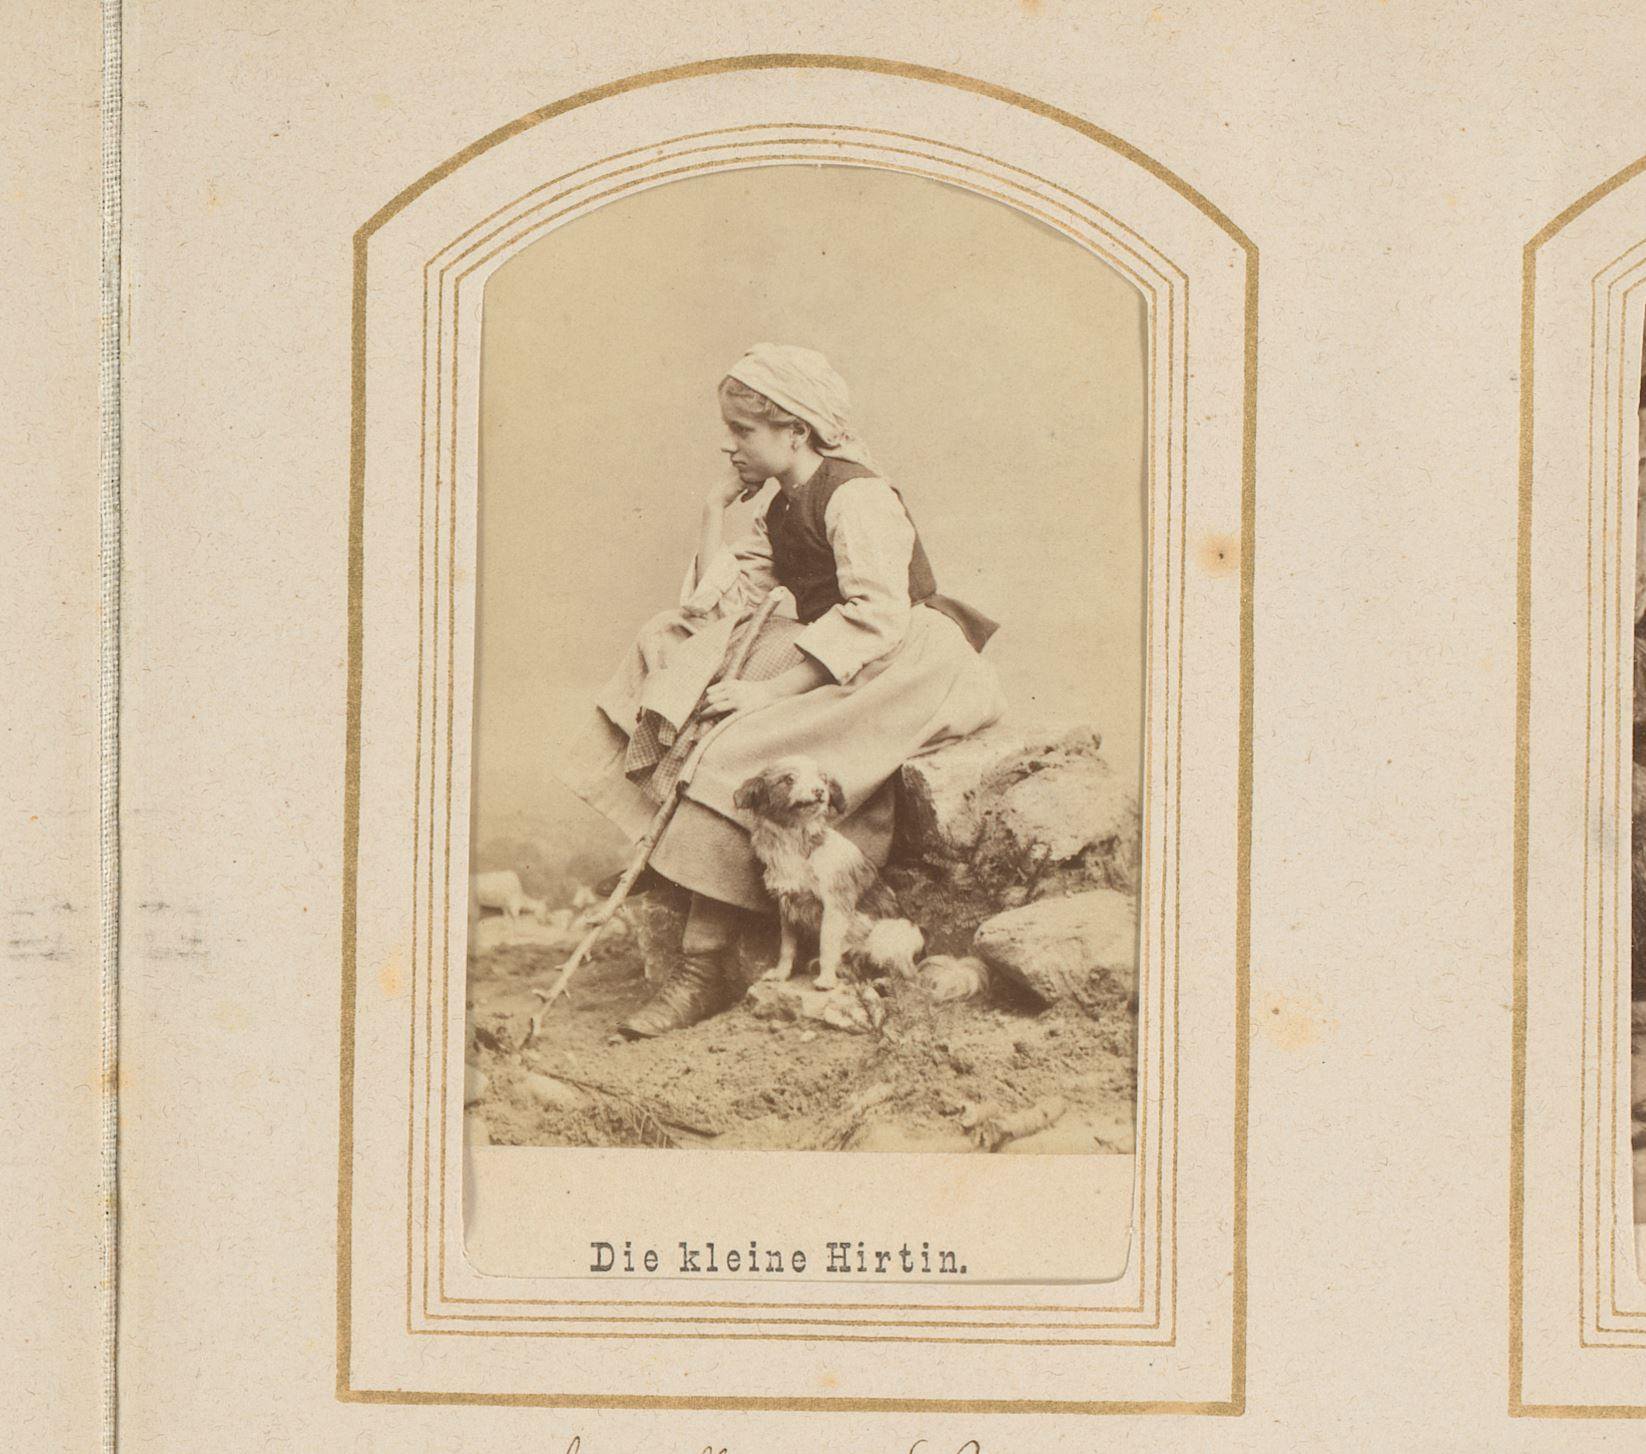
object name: album leaf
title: Die kleine Hirtin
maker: Anonymous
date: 1870-1890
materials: cardboard, photographic support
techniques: albumen print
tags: herding, herdsman, herdswoman, shepherd, shepherdess, cowherd, etc., dog, painting, drawing and the graphic arts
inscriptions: annotation: ‘Die kleine Hirtin’, number: ‘1212’